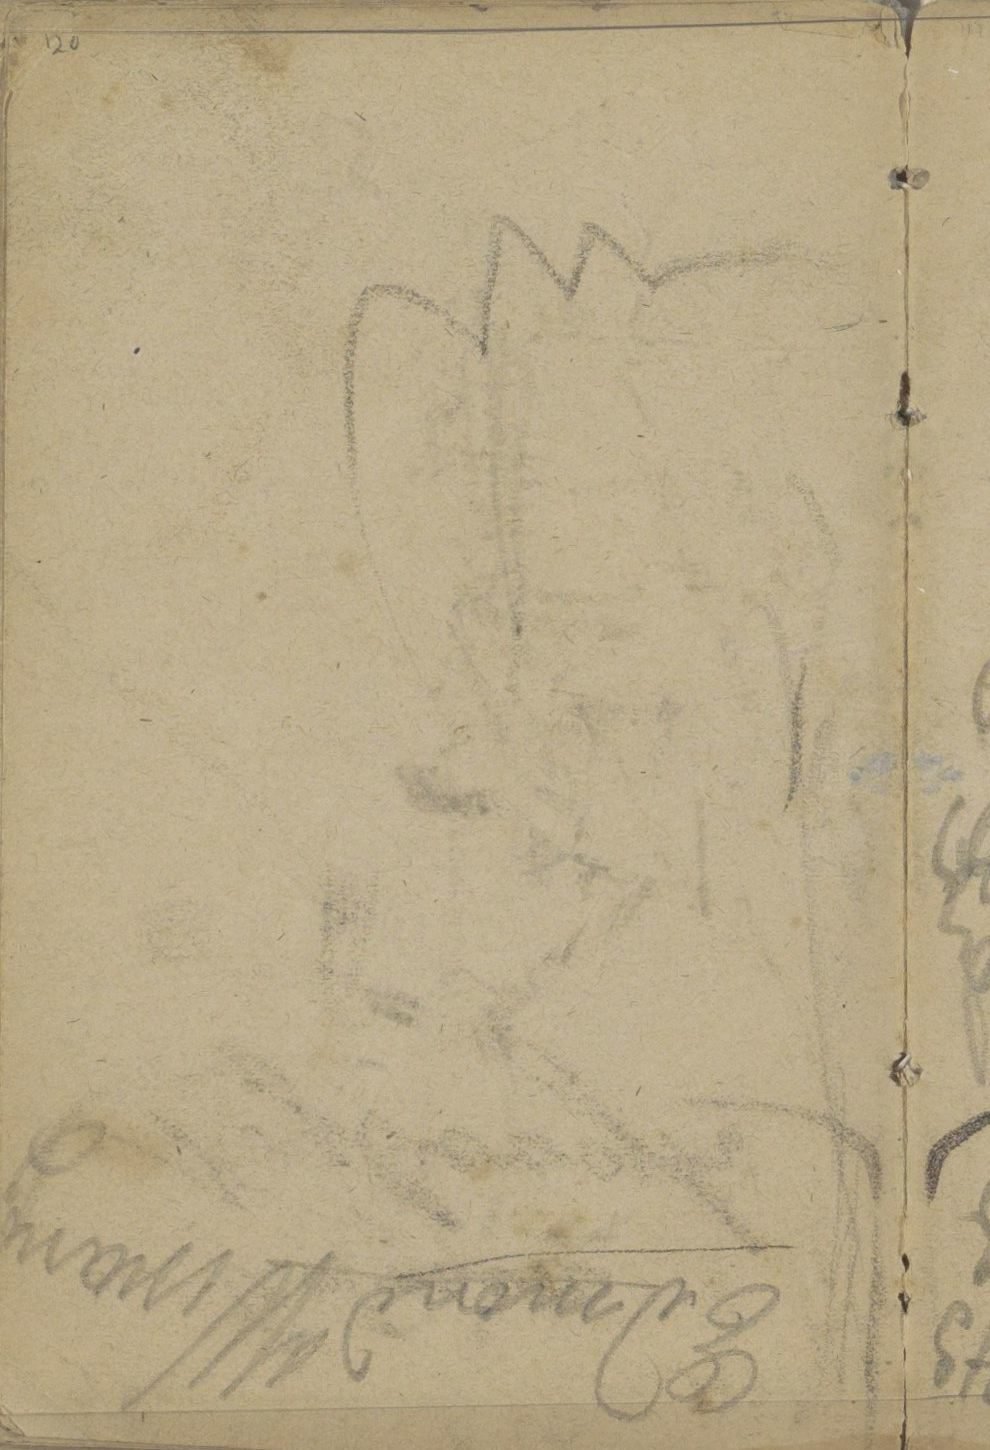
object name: sketchbook leaf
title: Studie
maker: george hendrik breitner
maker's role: draughtsman, painter, print maker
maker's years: 1857-1923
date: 1881-1883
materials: chalk, paper, pencil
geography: south holland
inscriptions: name: ‘Edmond Winandy’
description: Studie. Pagina 120 uit een schetsboek met 70 bladen.